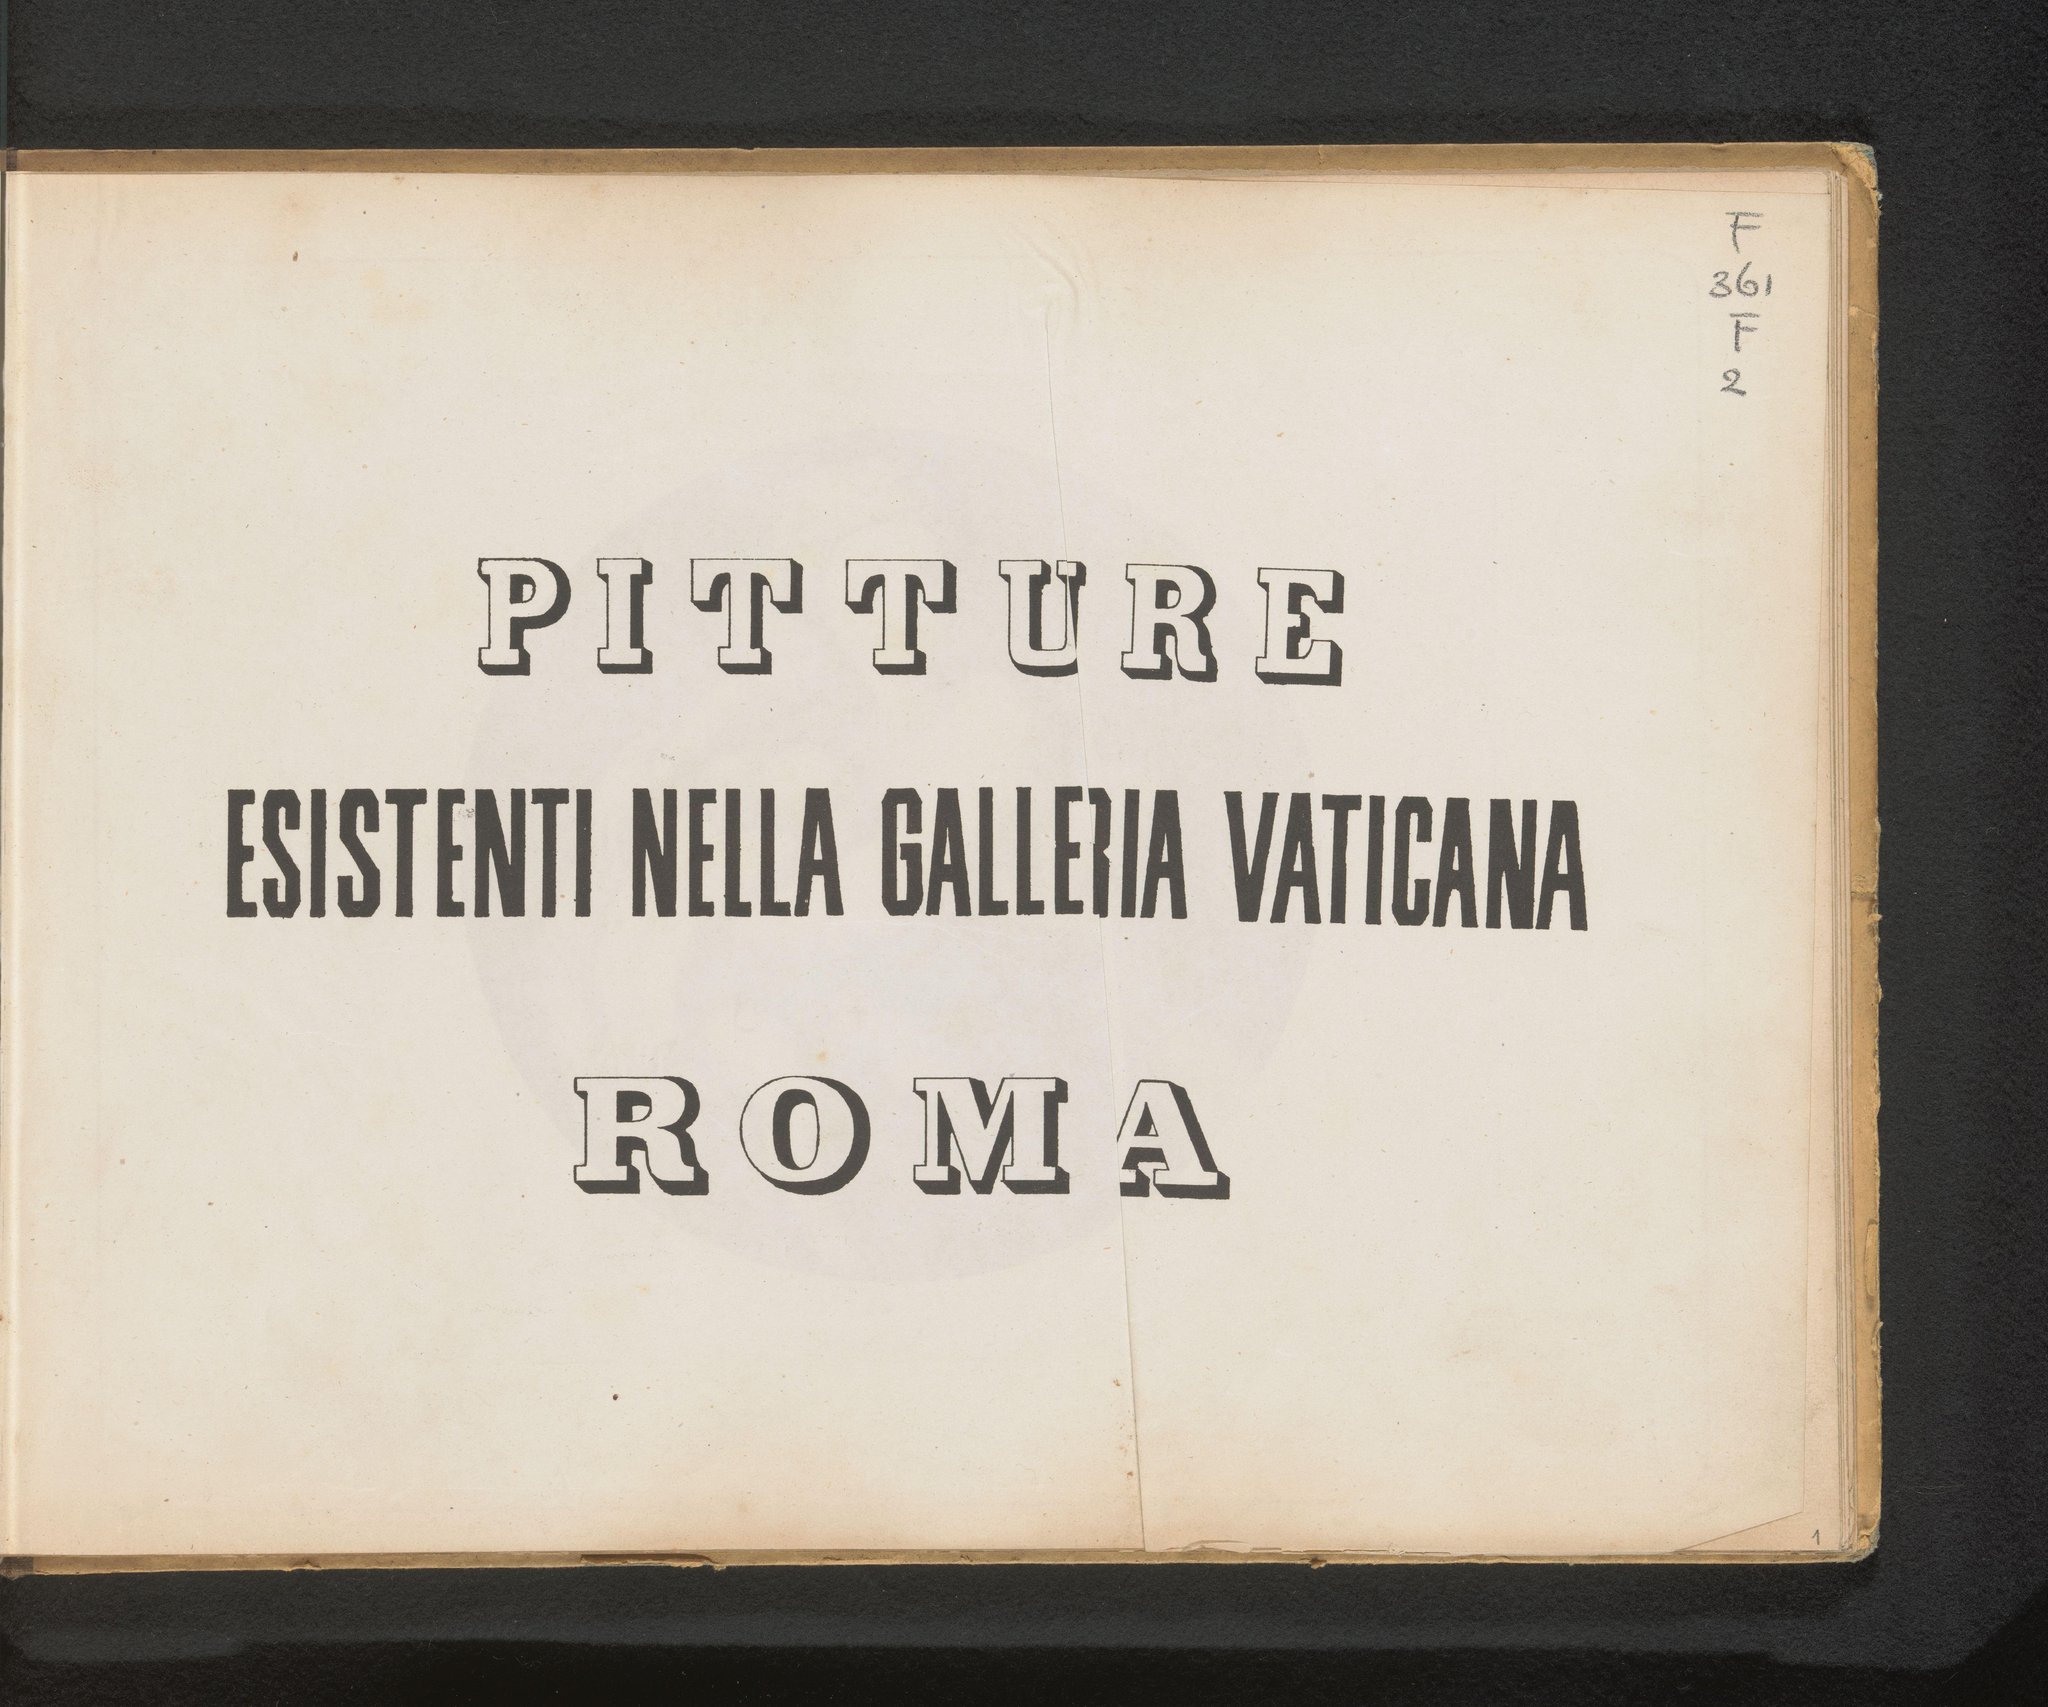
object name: book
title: Pitture esistenti nella Galleria Vaticana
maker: Anonymous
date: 1868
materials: cardboard, linen, paper, photographic support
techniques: albumen print, lithograph, printing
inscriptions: annotation: ‘MAR/ 1992’